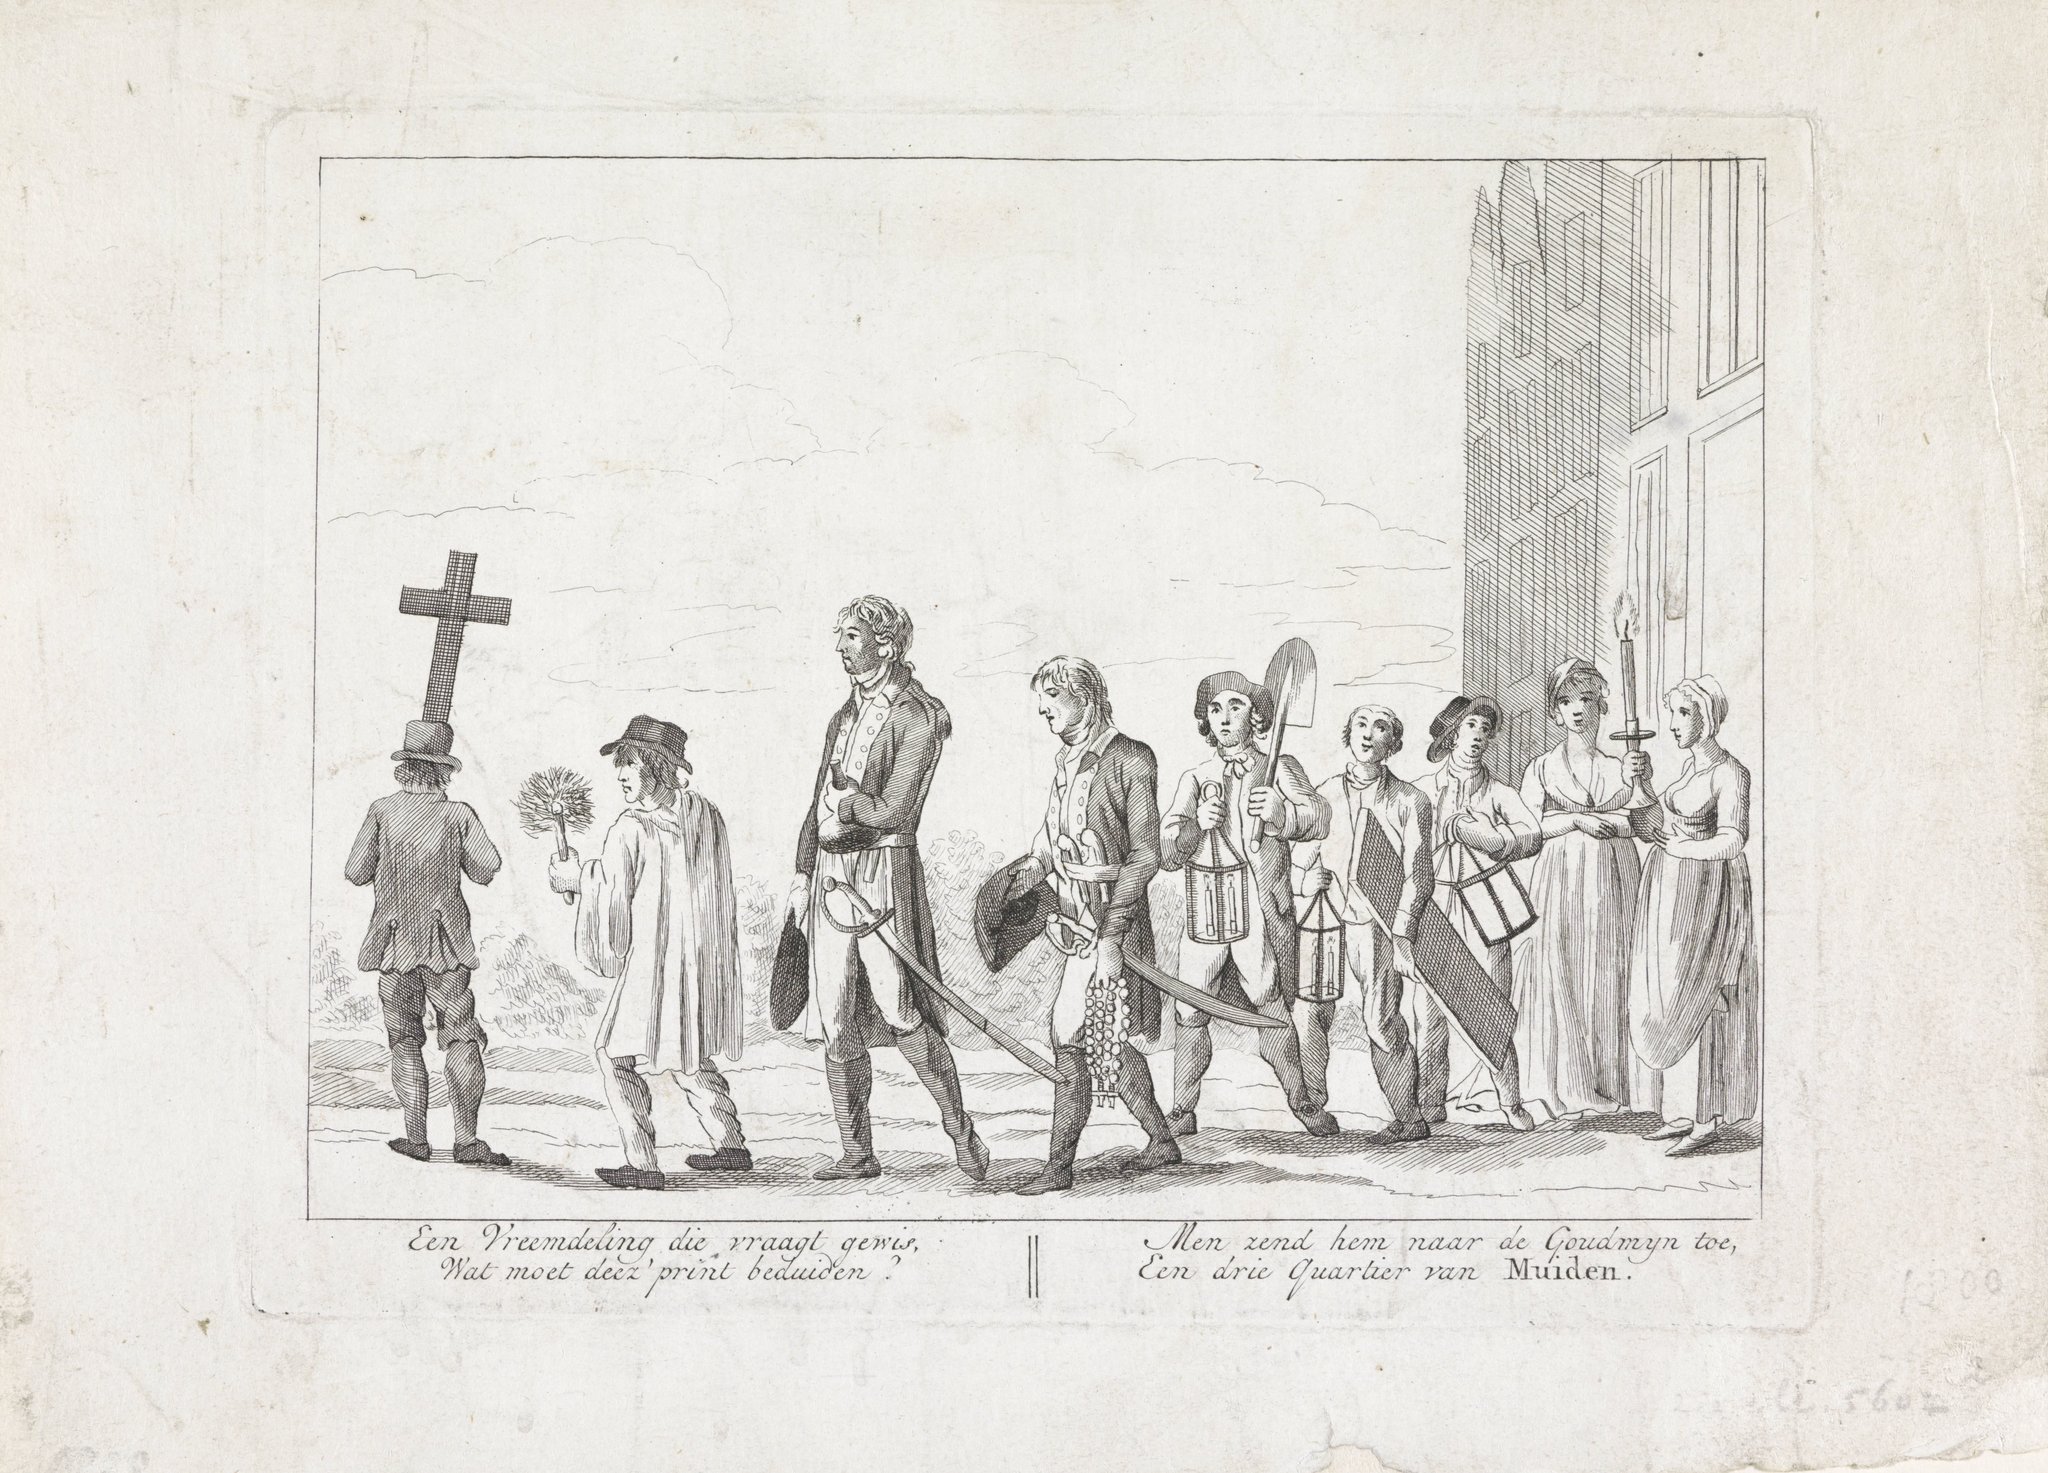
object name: print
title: Schatzoekers van Muiden, 1800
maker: Anonymous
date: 1800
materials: paper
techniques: etching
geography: netherlands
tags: amsterdam, digging for or finding of treasure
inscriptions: collector's mark: Lugt 2228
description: De schatzoekers van Muiden vertrekken in processie in de richting van de plaats van de vermeende schat. Vooraan draagt een man een kruis, daarachter de Duitse oplichter met een wijwaterkwast. Illustratie van het verhaal van het bedrog van de bijgelovige katholieke luitenant-kolonel Dirk Cornelis van der Meulen door een Duitse oplichter, te Muiden in de nacht van 12 op 13 augustus 1800. In de marge een vierregelig vers.